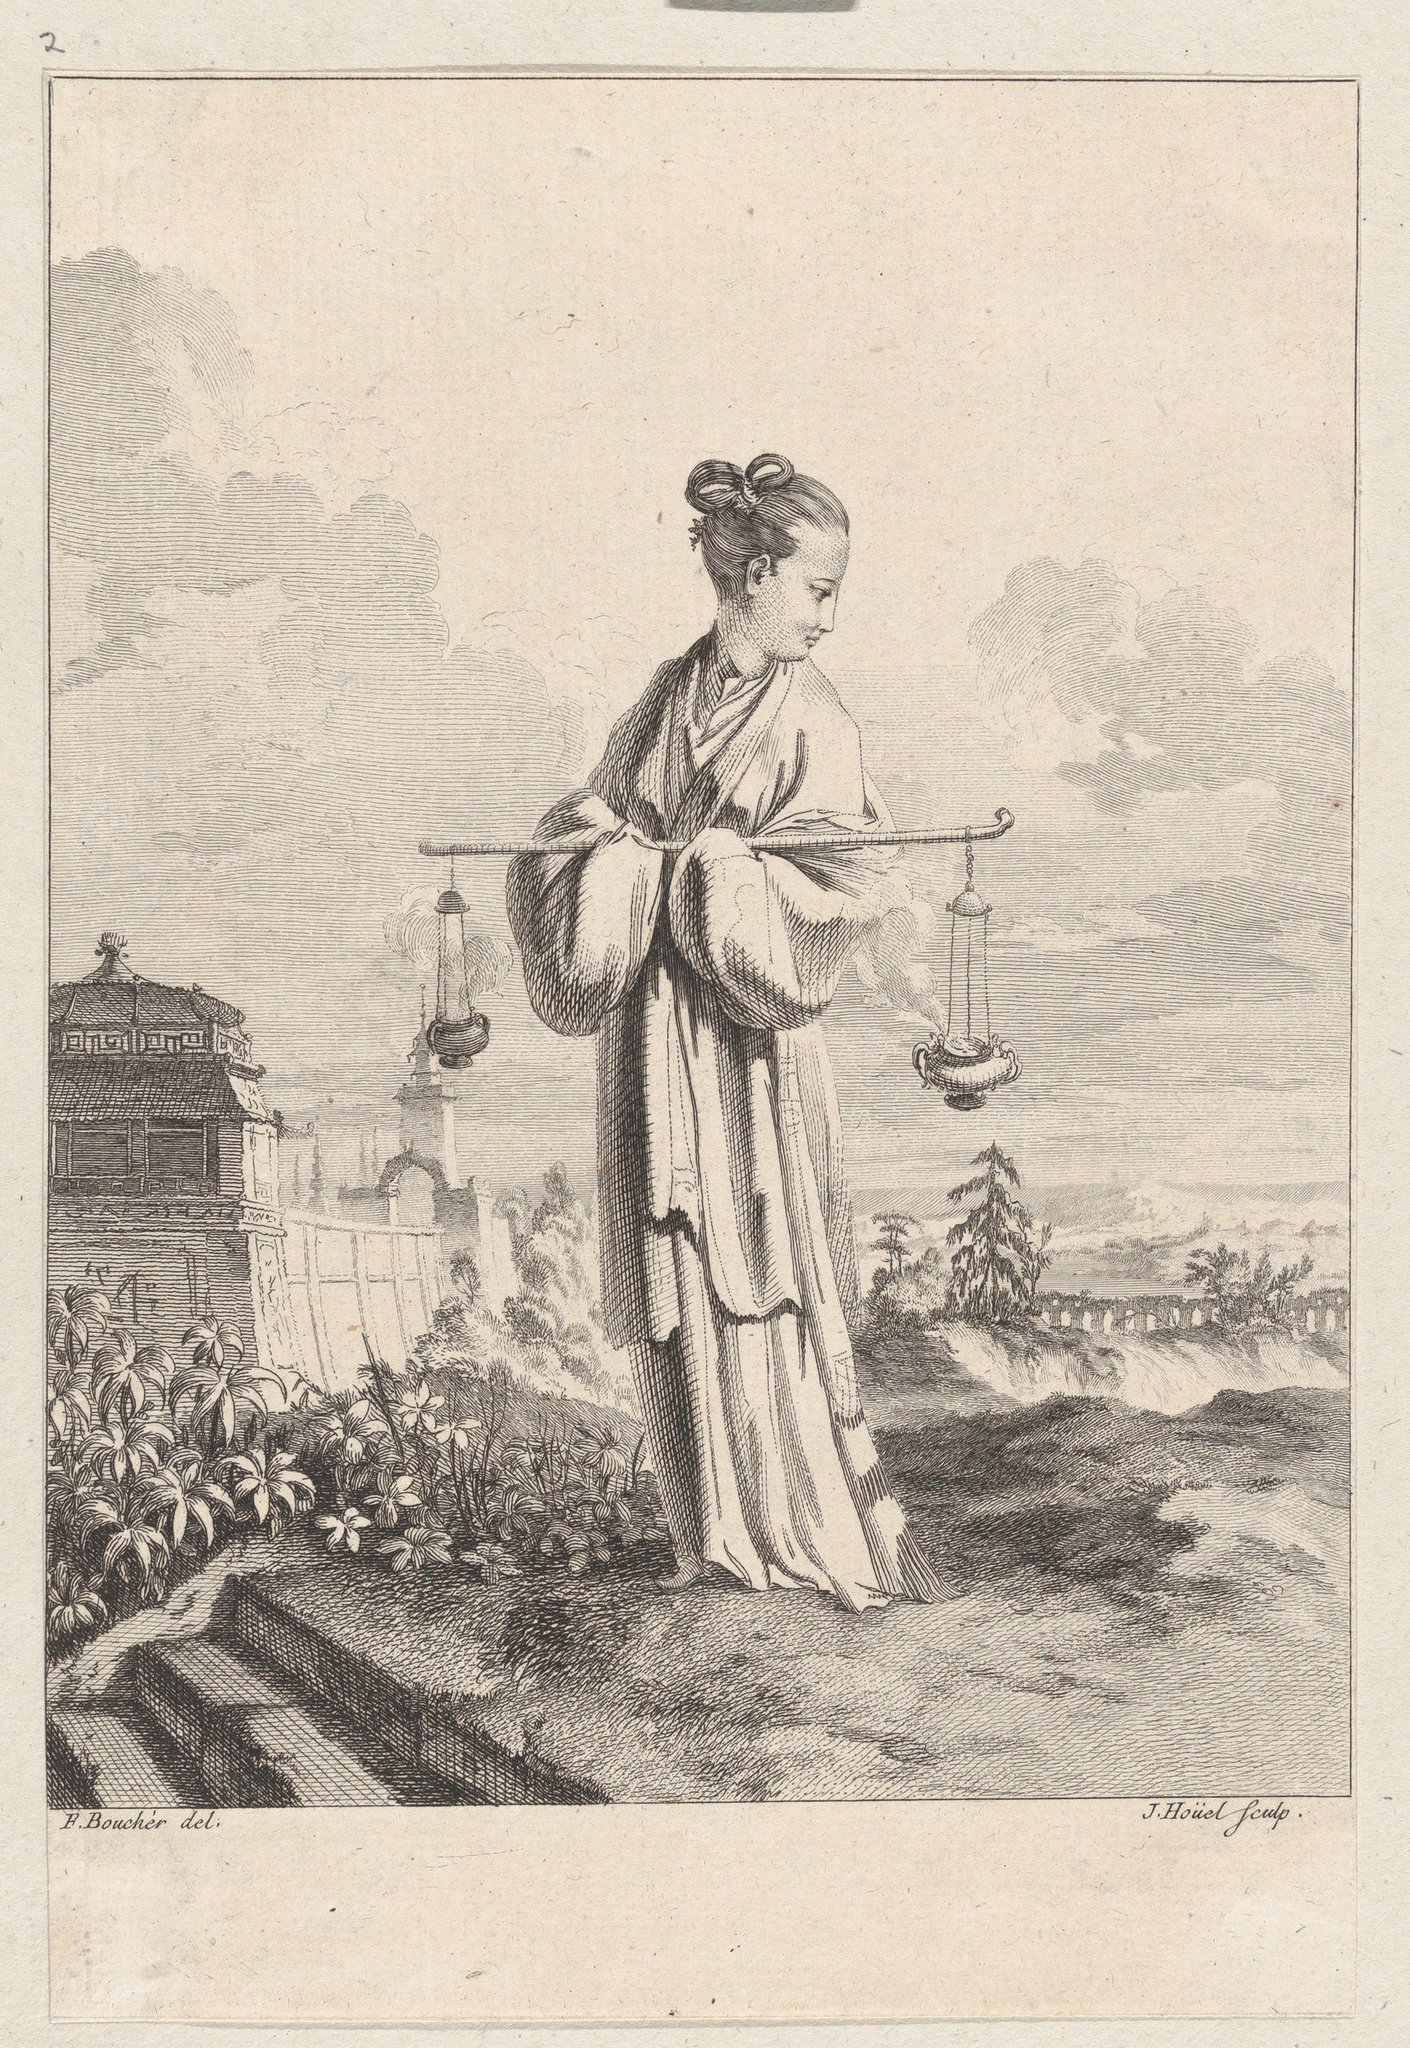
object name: print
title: Chinoiserie with a female figure holding burning perfumes, from Suite de Figures Chinoises. . .Tiré du Cabinet de Mr. d'Azaincourt (Series of Chinoiserie Figures. . .From the Chambers of Mr. d'Azaincourt)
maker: jean pierre louis laurent hoüel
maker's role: artist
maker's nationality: french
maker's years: 1735-1813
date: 1755-1776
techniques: engraving, etching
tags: chinoiserie,women